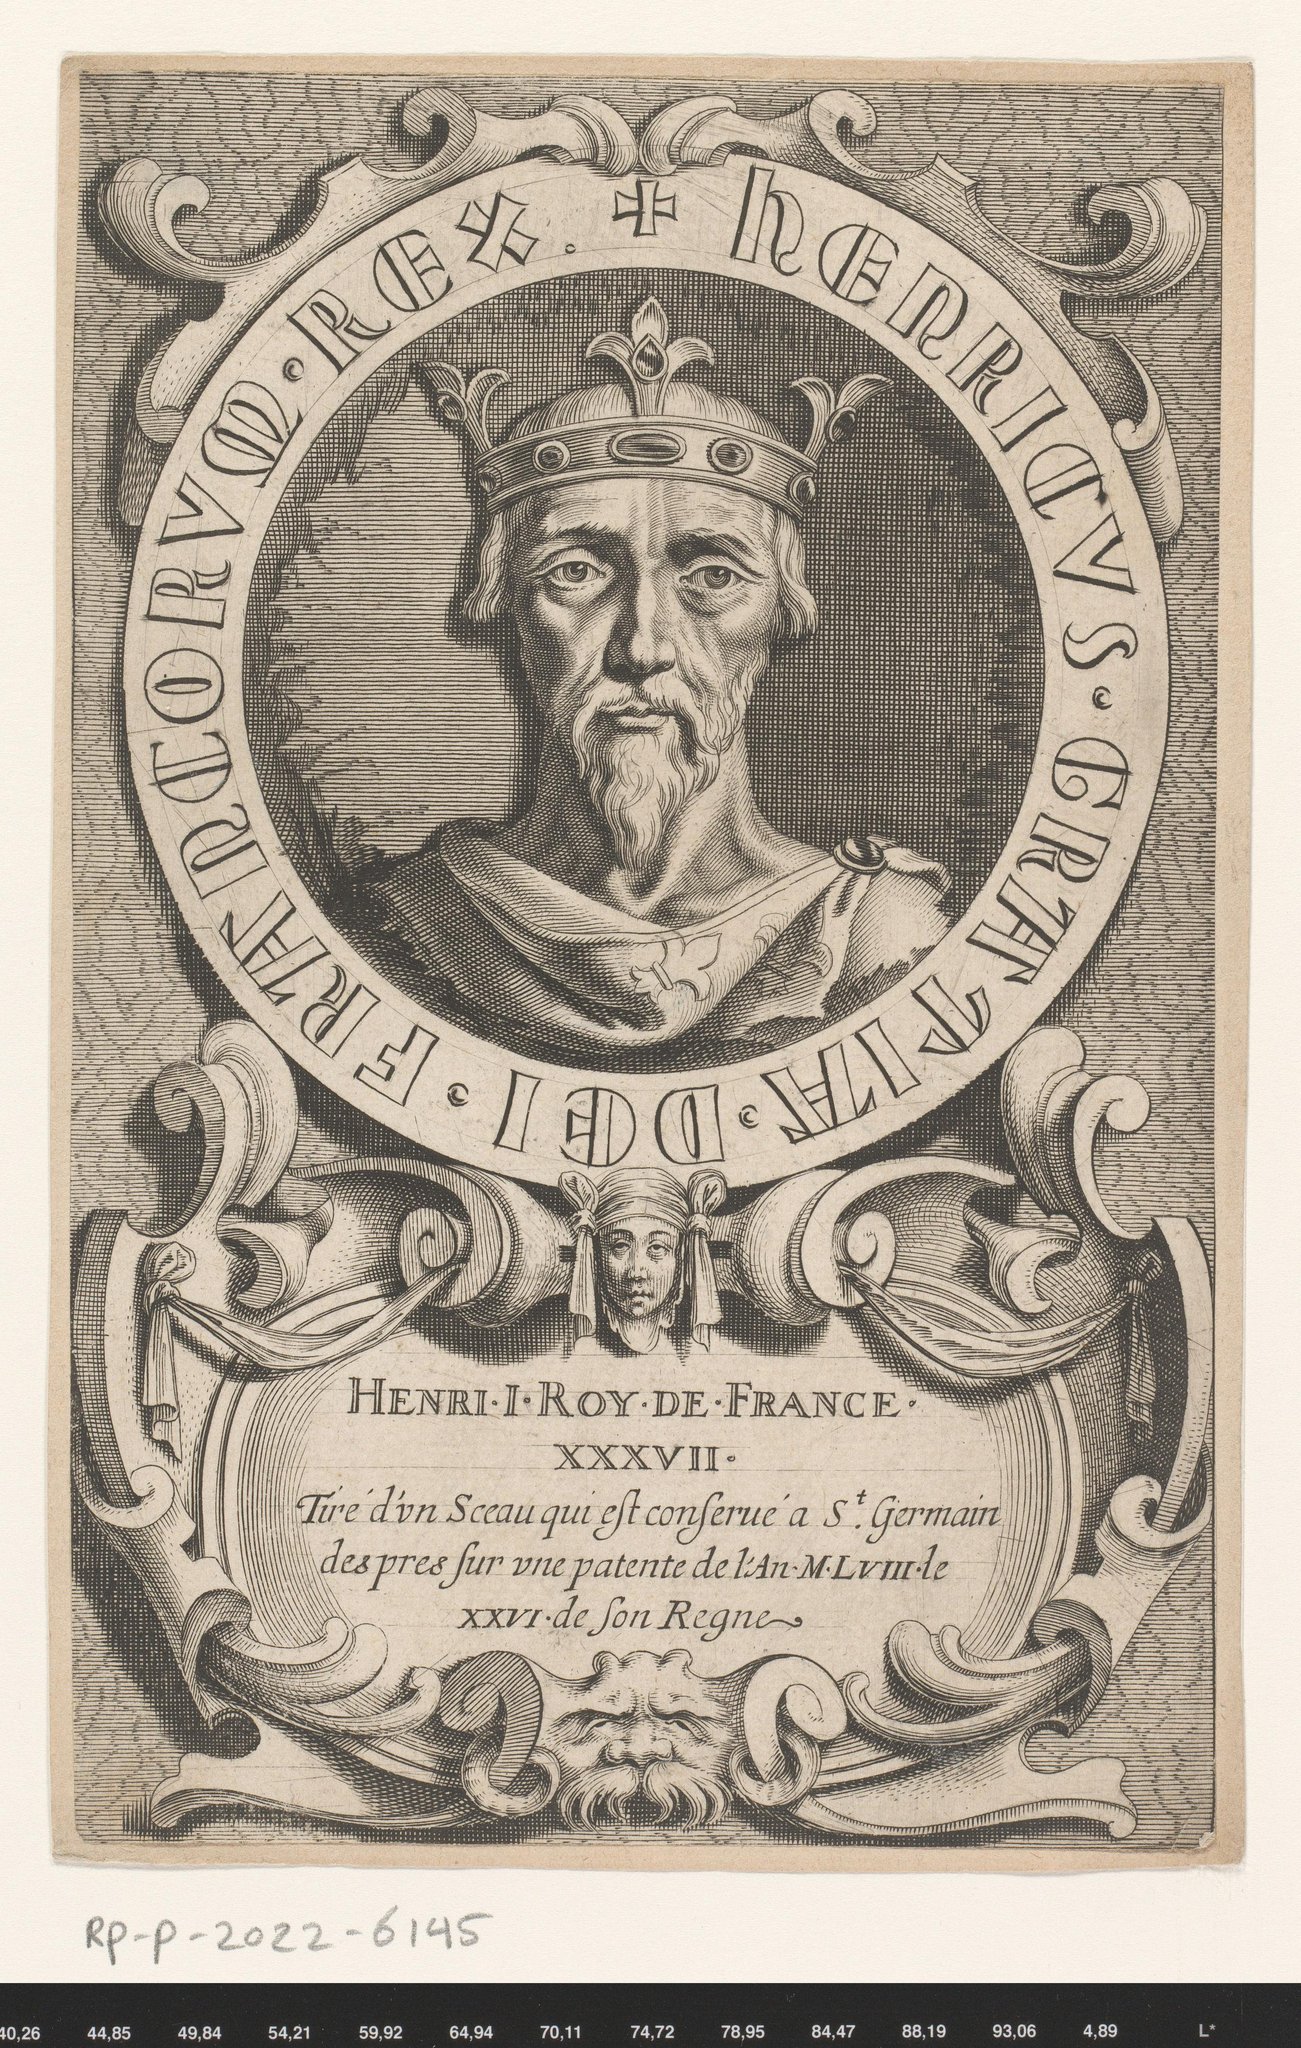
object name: print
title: Portret van Hendrik I van Frankrijk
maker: jacques de bie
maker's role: print maker, publisher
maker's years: 1581-1647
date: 1636-1685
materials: paper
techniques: engraving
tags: historical persons, king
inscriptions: collector's mark: Lugt 2228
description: Prent waarschijnlijk uit: Bie, Jacob de. Les vrais portraits des rois de France. (...) Parijs: Jean Camusat, 1636. Of uit: Mézeray, François Eudes de. Histoire de France, depuis Faramond jusqu'au regne de Louis le Juste. (...) Parijs: Denis Thierry, Jean Guignard en Claude Barbin, 1642-1685.